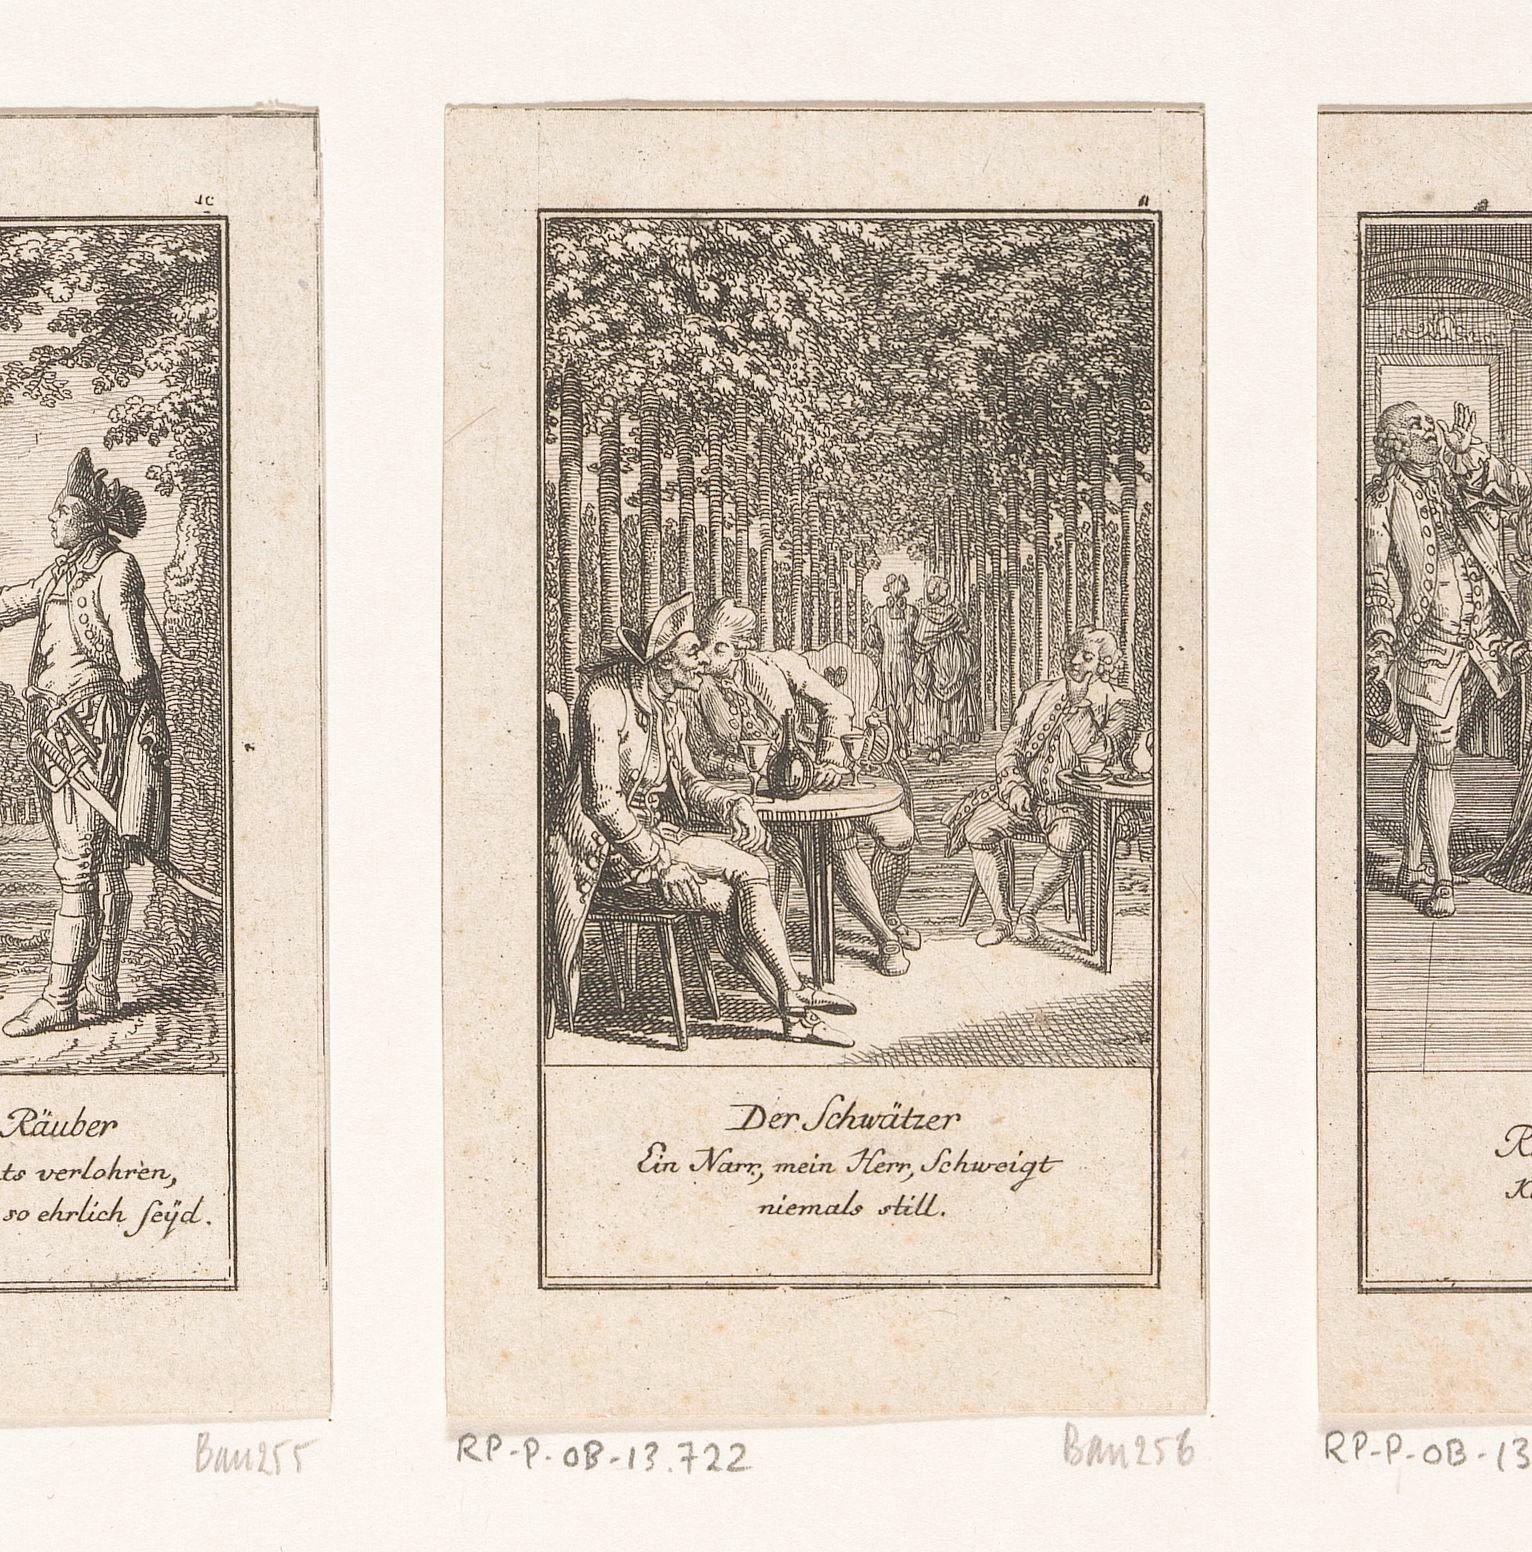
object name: print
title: Der Schwätzer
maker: daniel nikolaus chodowiecki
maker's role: draughtsman, print maker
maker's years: 1726-1801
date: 1775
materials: paper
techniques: etching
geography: berlin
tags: literature, wine ~ alcoholic drinks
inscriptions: collector's mark: Lugt 2228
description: Elfde scène uit een serie van twaalf scènes die de 'Fabeln und Erzählungen' door Christian Fürchtegott Gellert illustreren. De scènes werden op een plaat geëtst. Deze serie is ook gebruikt in: 'Genealogischer Calender für West-Preußen auf das Jahr 1776, zu Berlin herausgegeben. Auf Kosten der Königl. Academie der Wissenschaften'.